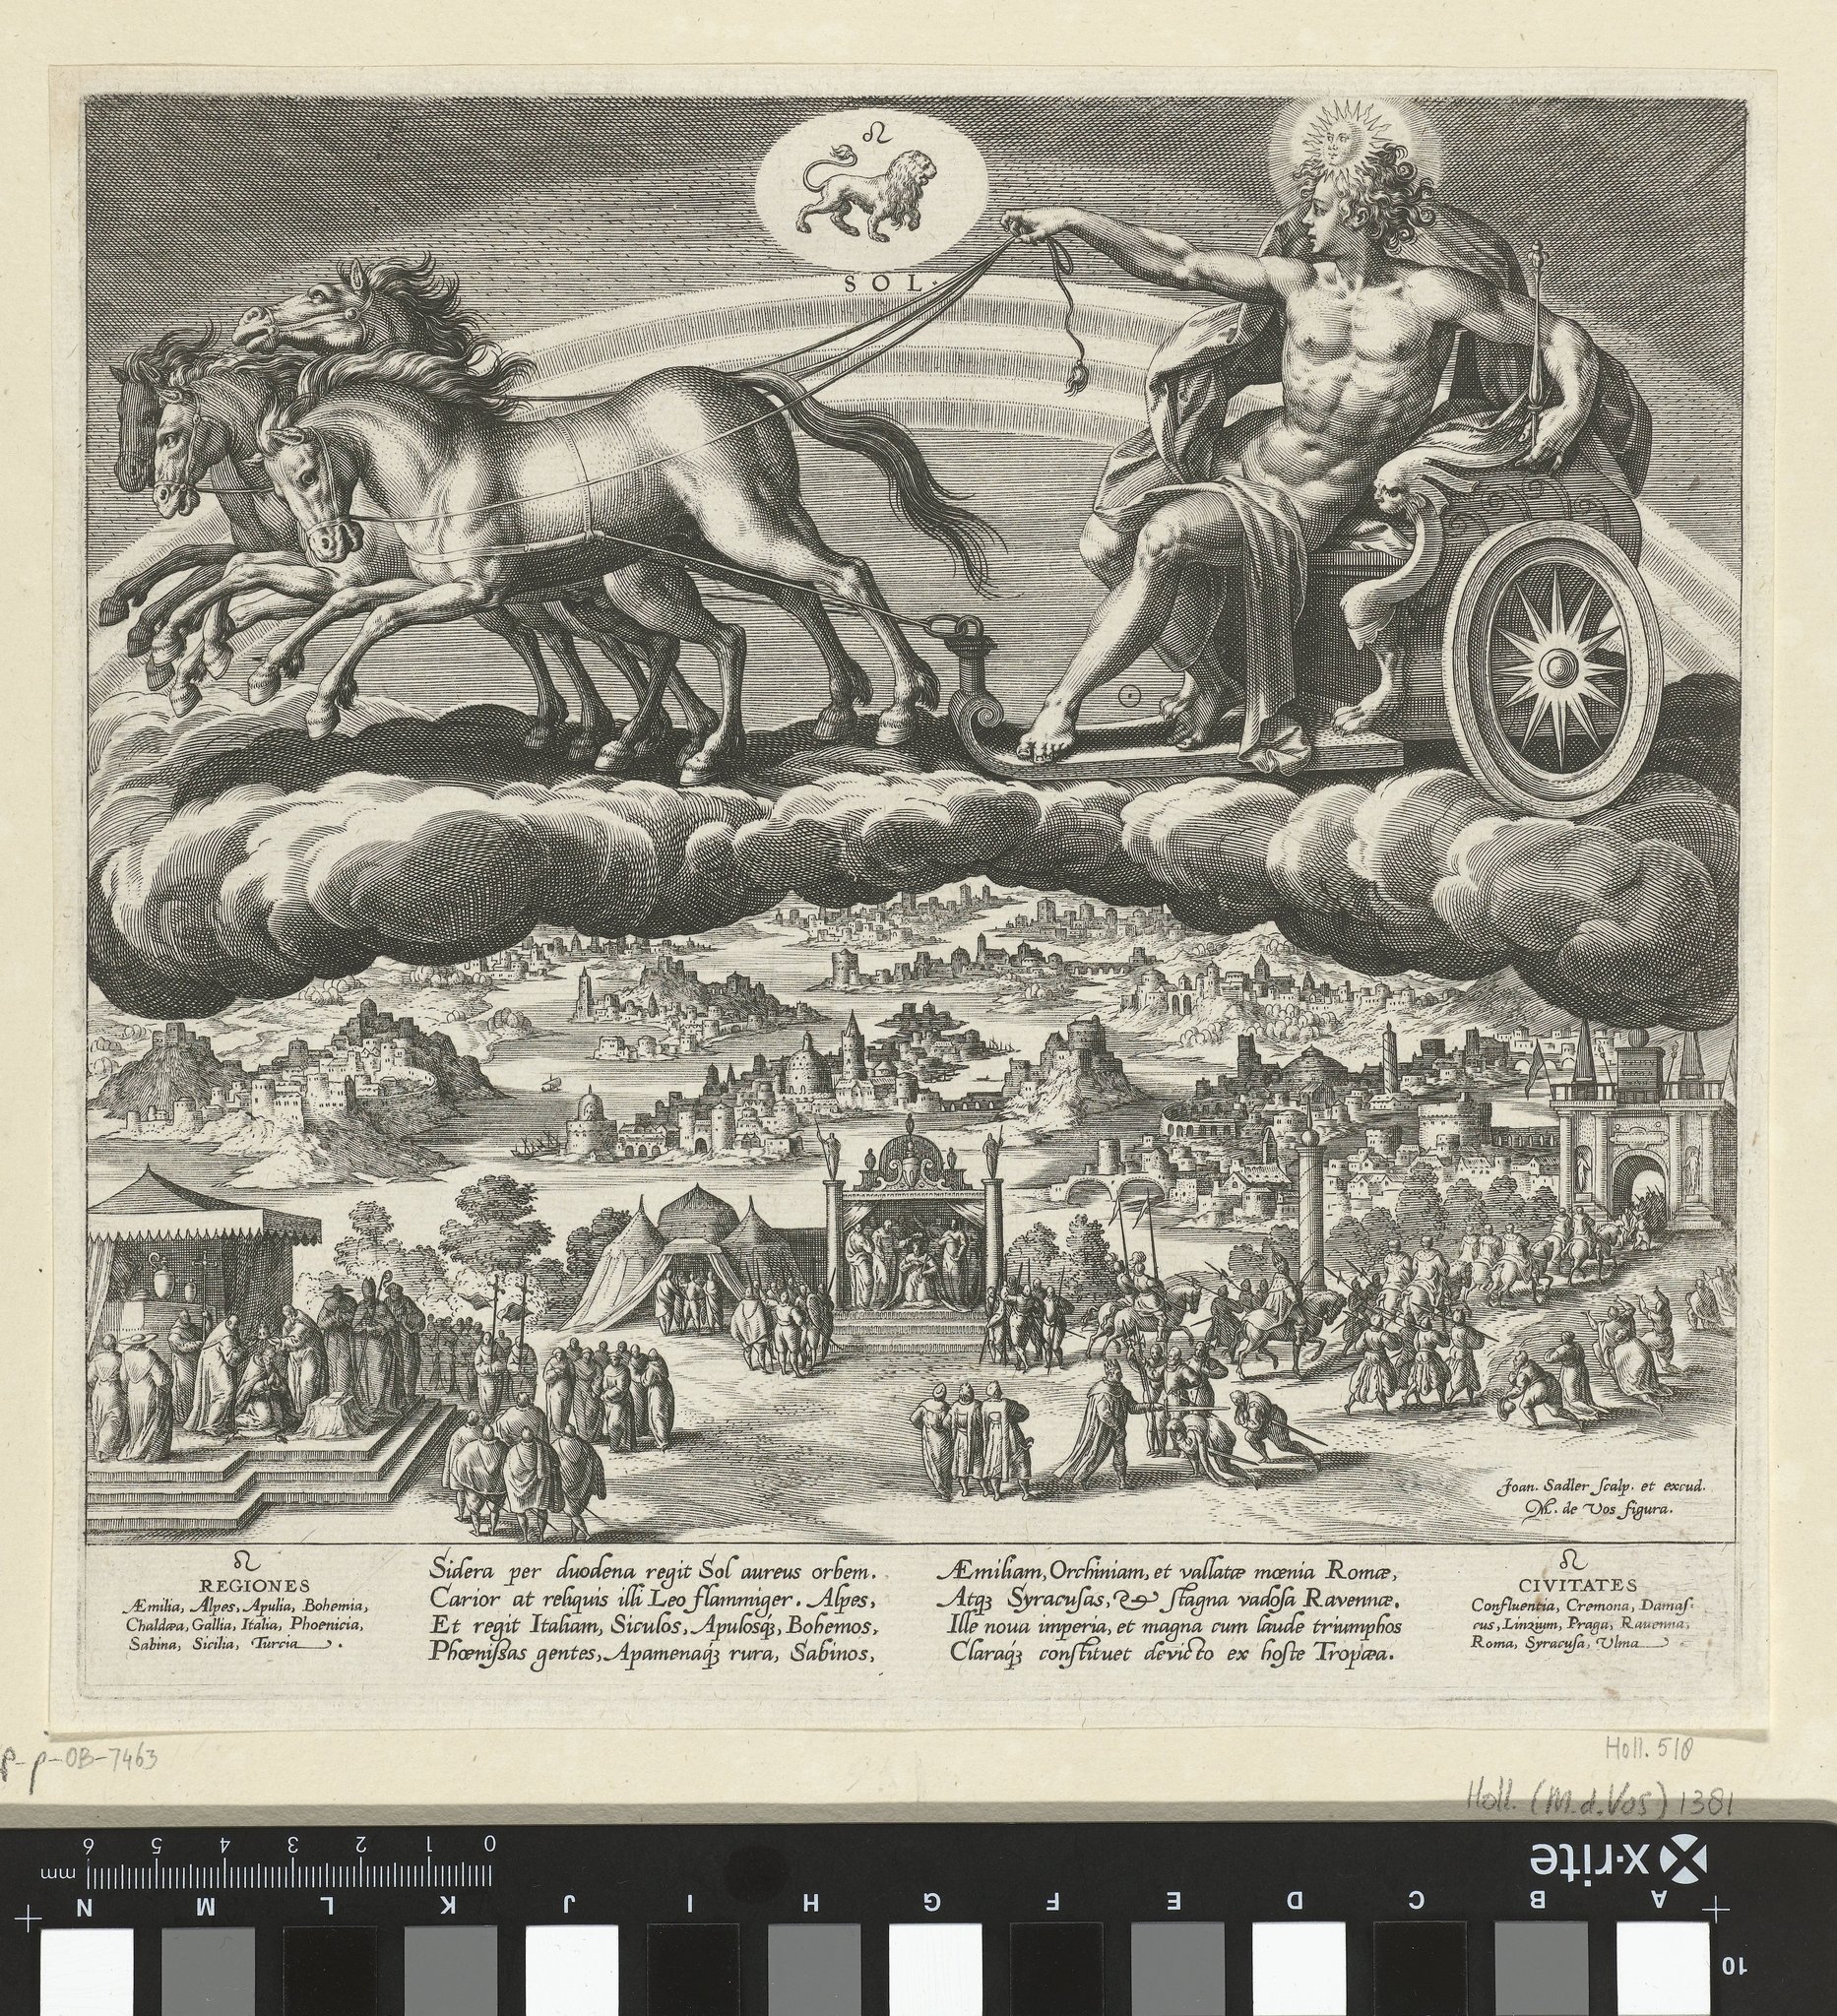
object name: print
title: Planetarum effectus et eorum in signis zodiaci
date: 1585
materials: paper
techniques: engraving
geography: antwerp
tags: papal coronation, (personifications of the) planets with their 'children', so-called 'planetenkinder', accompanied by the corresponding zodiacal signs, the chariot of the sun, triumphal entry and public reception, pageant, 'entrée solennelle', 'joyeuse entrée', coronation of a ruler, leo (zodiacal sign of july), becoming a knight, knighting, italy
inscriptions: collector's mark: Lugt 240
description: De god Apollo als Sol, op de wolken rijdend op zijn zegewagen, die wordt getrokken door vier paarden. Middenboven het sterrenbeeld Leeuw. Onderaan een heuvelachtig landschap (Italië en Bohemen) waarin verschillende hoogwaardigheidsbekleders. Links wordt een paus gekroond. In het midden de kroning van een koning en het tot ridder slaan van een man. Rechts een koninklijke intrede. In de marge een Latijns lofdicht op de invloed van de zon op de streken Italië en Bohemen. De prent maakt deel uit van een zevendelige reeks met als onderwerp de invloed der planeten op de wereld.